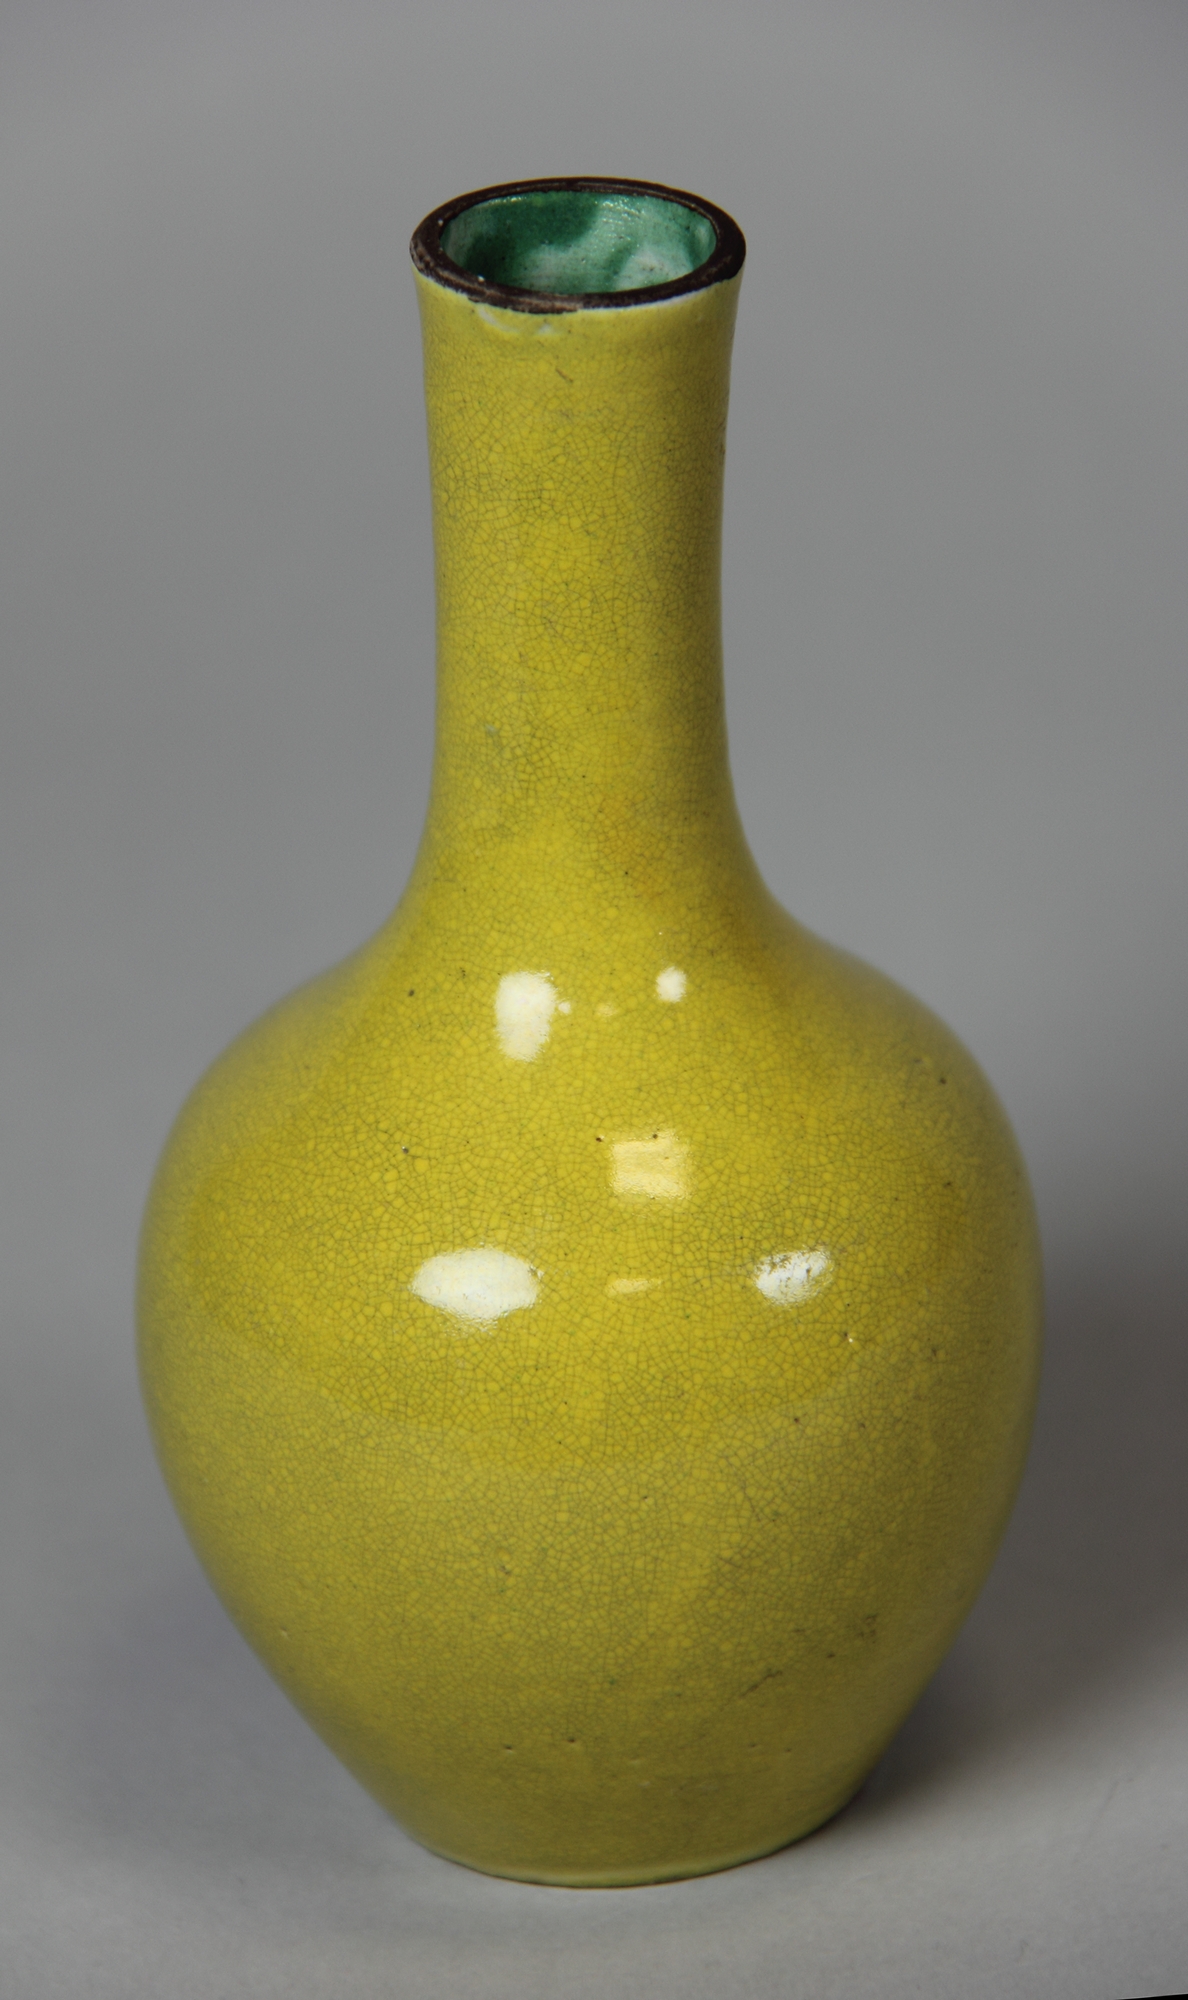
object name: vase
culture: chinese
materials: glaze, porcelain